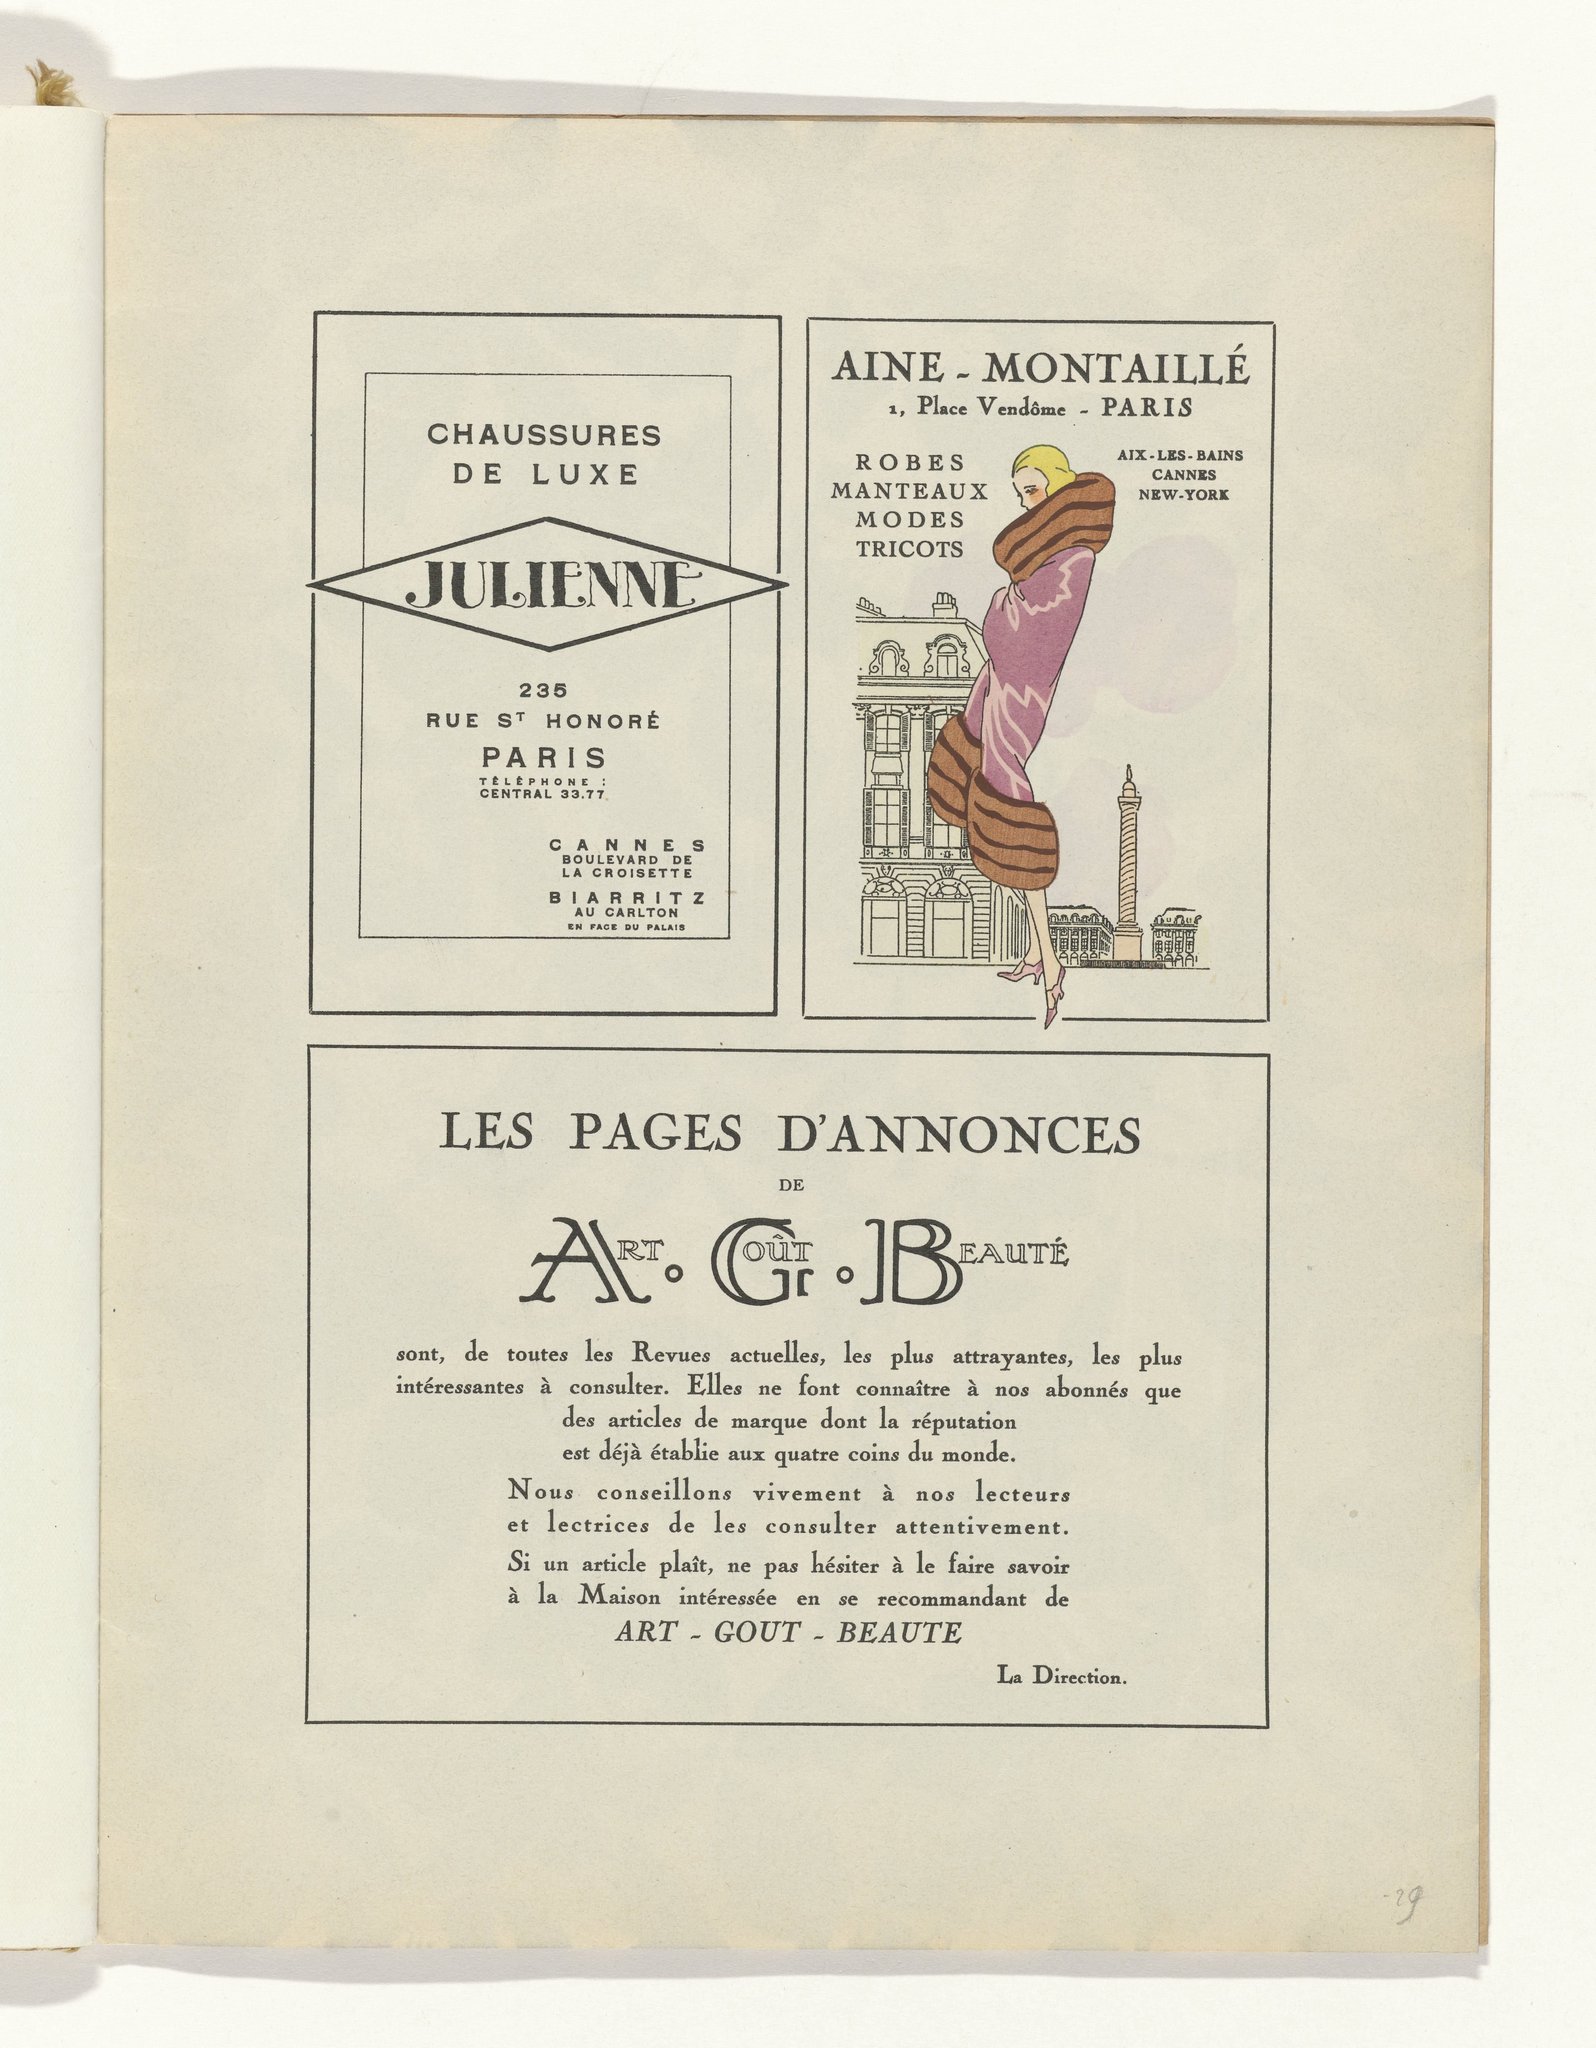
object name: fashion print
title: Art - Goût - Beauté, Feuillets de l' élégance féminine, Novembre 1928, No. 99, 9e Année, p. 29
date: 1928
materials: paper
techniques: hand coloring, lithograph, pochoir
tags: border, ribbon, braid (+ fur used for clothes), coat (+ women's clothes), fashion plates, shoes, sandals (+ women's clothes)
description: Drie verschillende advertenties, onder andere voor schoenen, jurken en mantels. Pagina uit het modetijdschrift Art-Goût-Beauté (1920-1933).